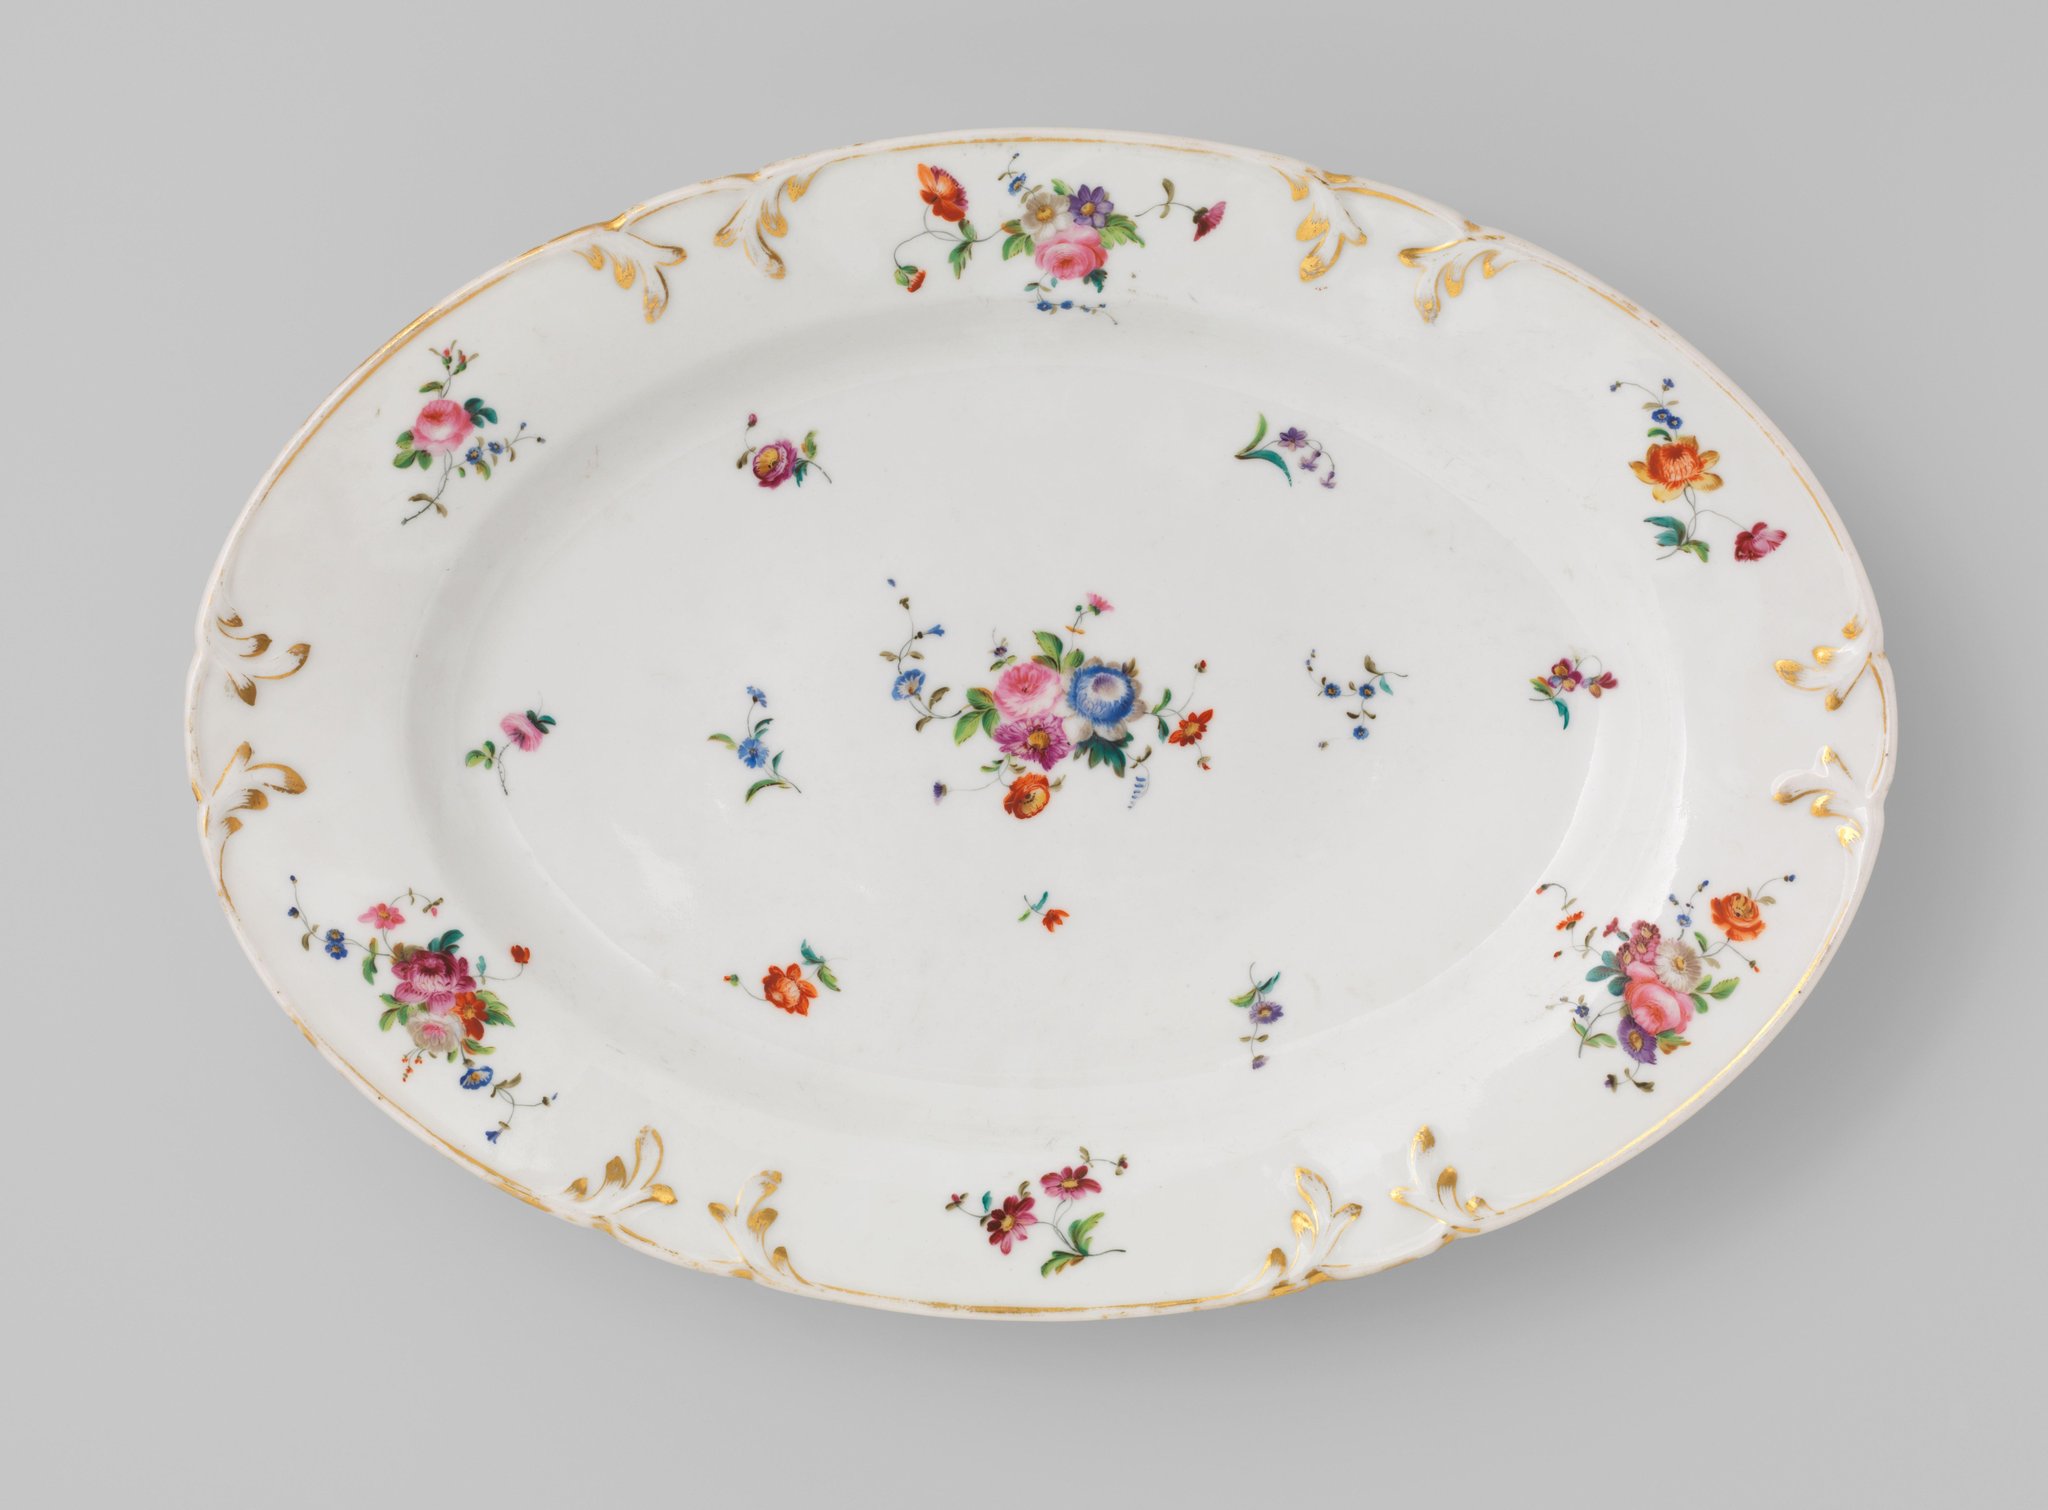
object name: service set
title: Dish with bouquets and flower sprays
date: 1839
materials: glaze, gold, paint, porcelain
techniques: firing, forming, gilding, turning, vitrification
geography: paris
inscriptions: mark: ‘DENUELLE/ Boulevard St. Denis 18/ à Paris’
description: Ovale schotel van porselein met een gelobde rand, beschilderd op het glazuur in blauw, rood, roze, groen, geel, paars, zwart en goud. Op het plat boeketten van verschillende bloemen en strooibloemen. Vanuit de gelobde, gouden rand, gemodelleerde bladranken in reliëf, aangezet met goud. Hiertussen boeketten. Dubbele voetring. Gemerkt op de onderzijde met 'DENUELLE/ Boulevard St. Denis 18/ à Paris'.